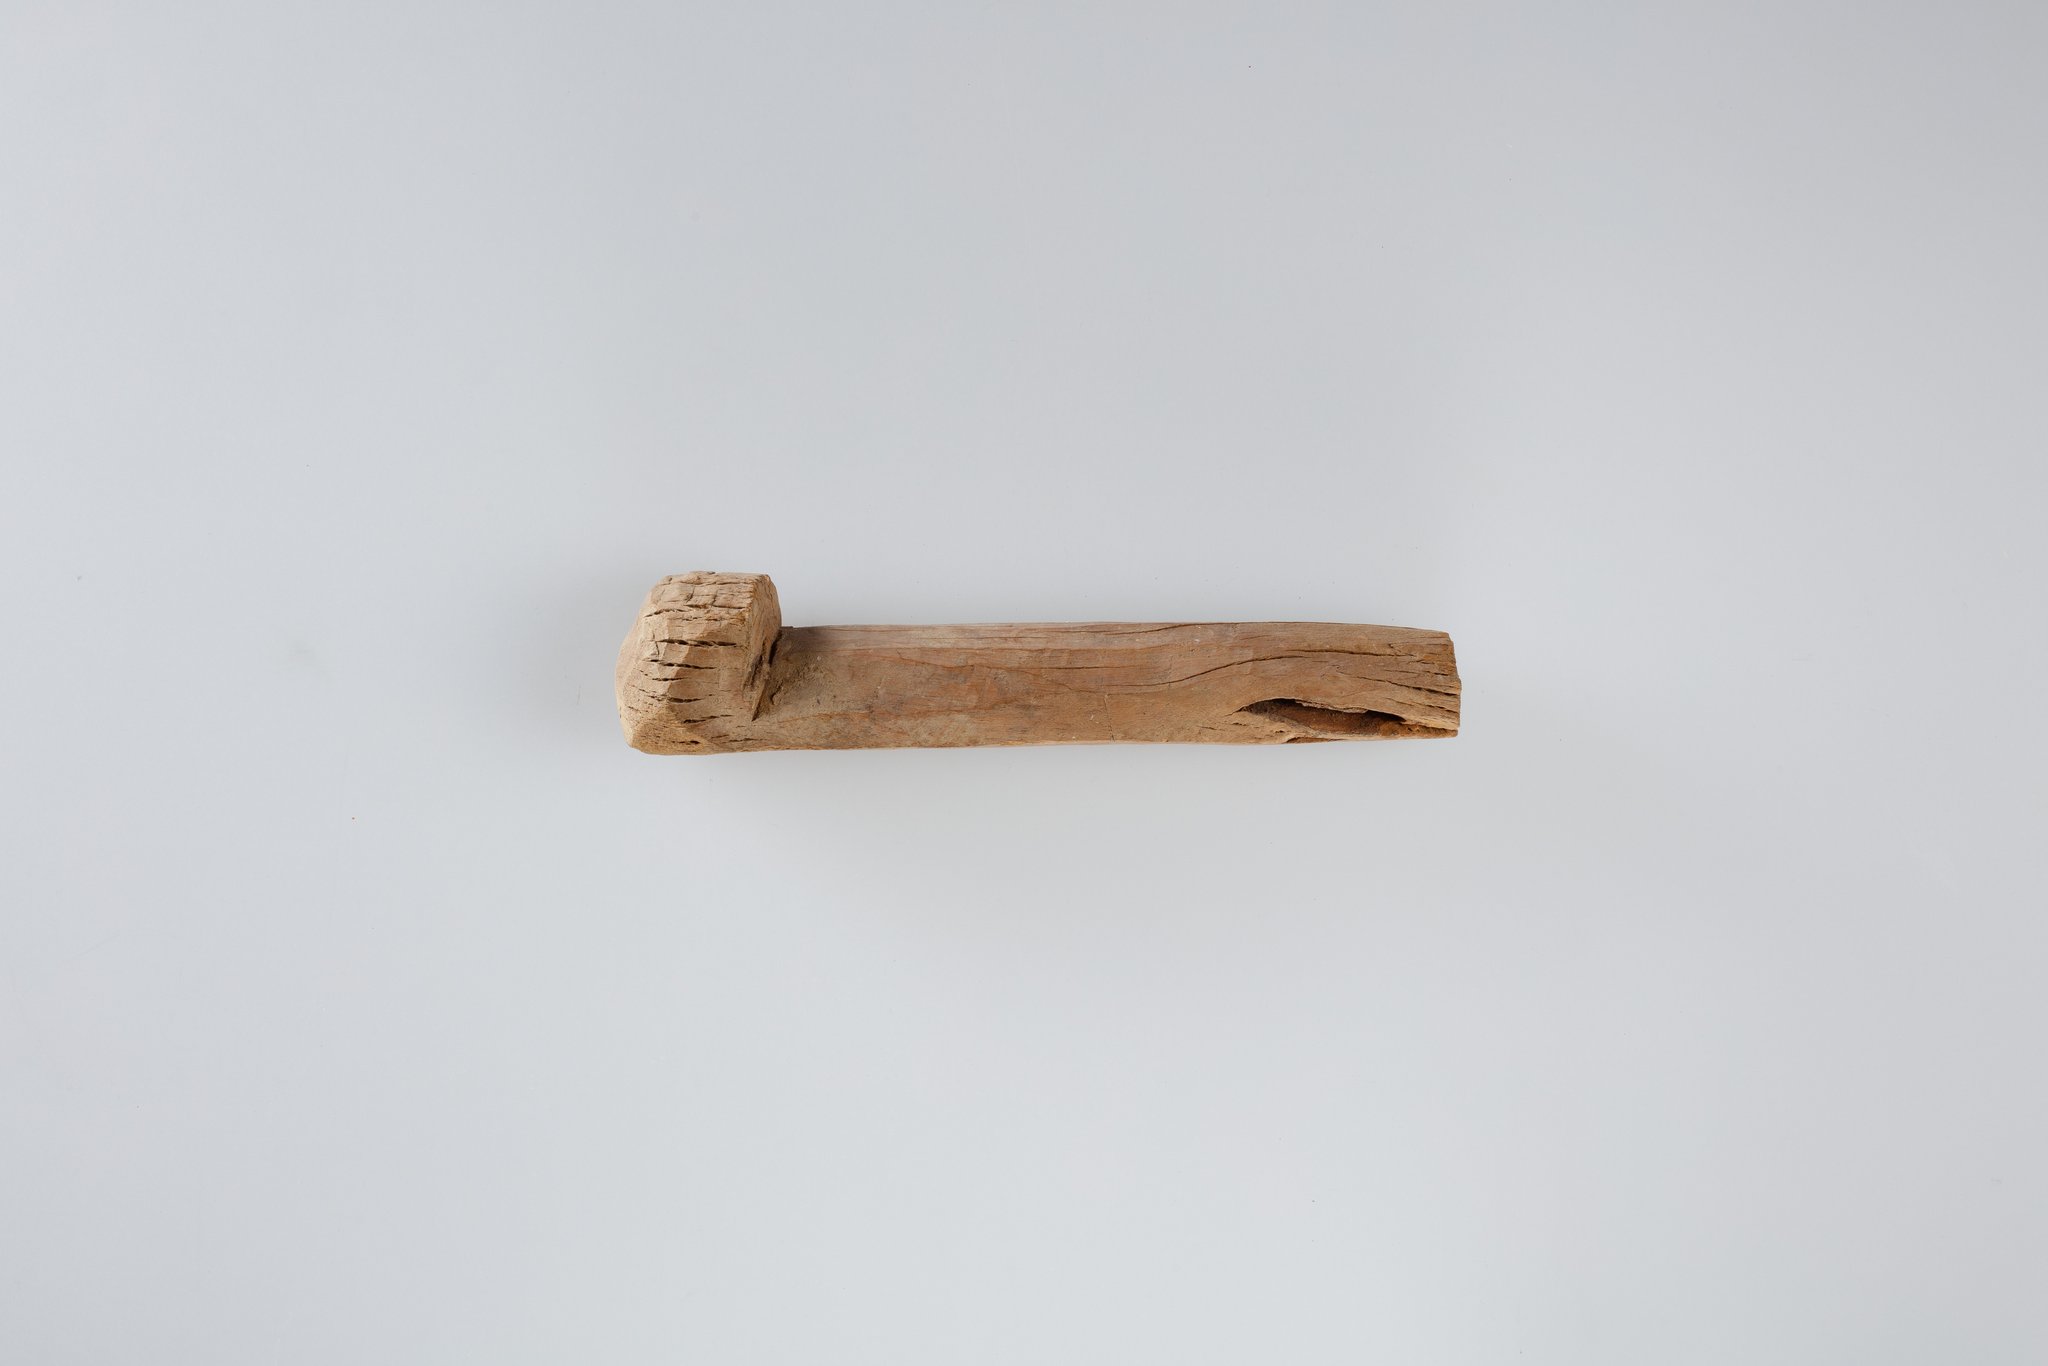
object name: bolt, door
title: Door Bolt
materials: wood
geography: egypt